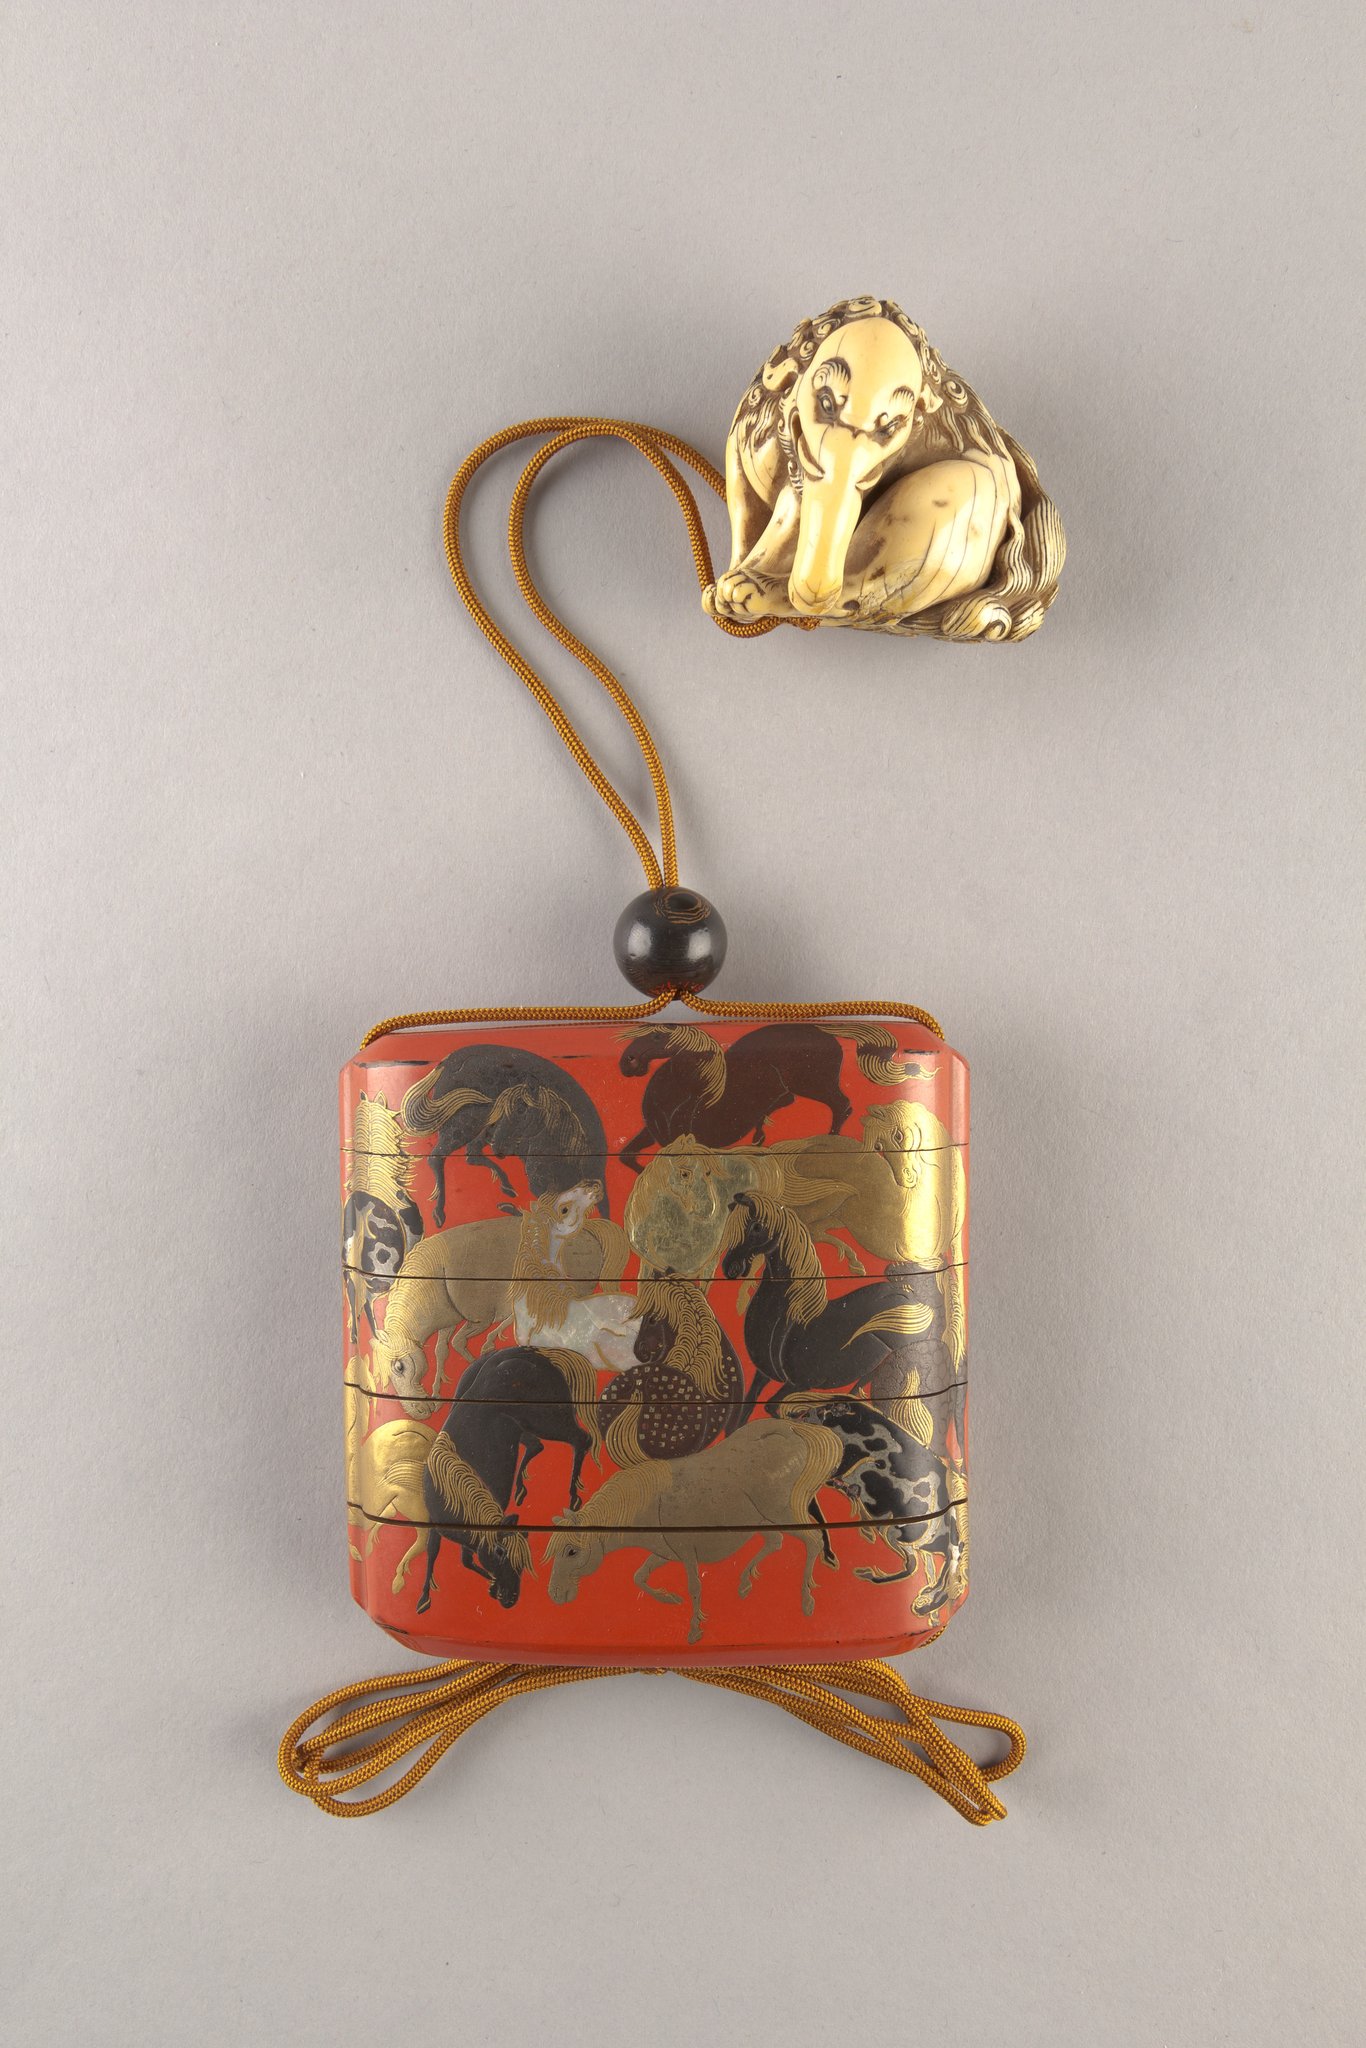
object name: inrō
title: Inrō with One Hundred Horses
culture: japanese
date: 1734-1766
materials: foil, gold, lacquer, mother of pearl, silver, wood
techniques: hiramakie, inlay, lacquer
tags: horses